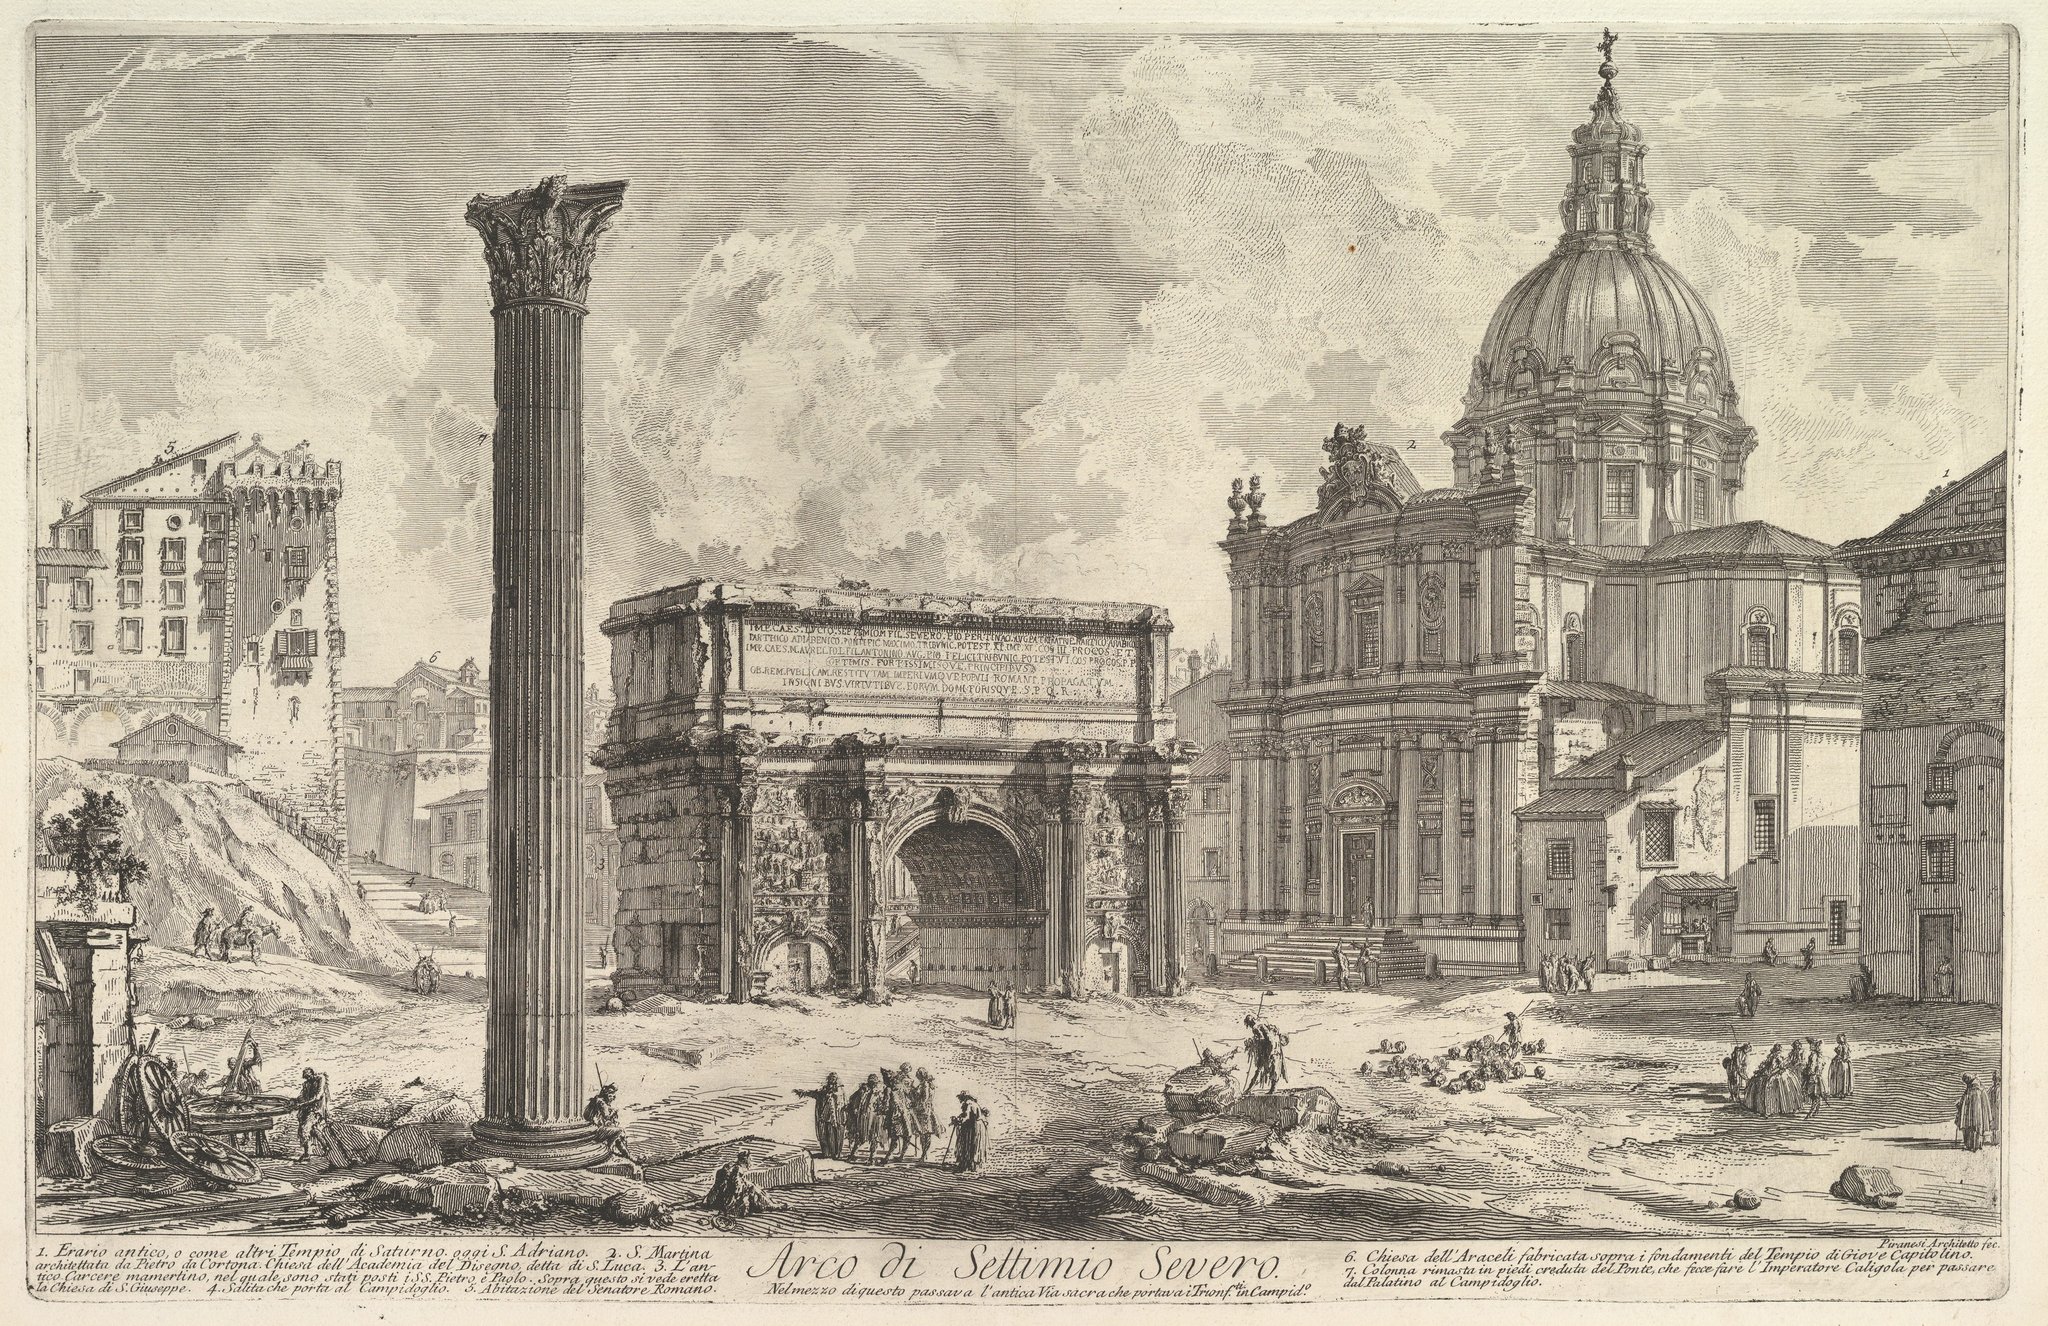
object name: print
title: The Arch of Septimius Severus, with the Church of S. Martina on the right (Arco di Settimio Severo), from "Vedute di Roma"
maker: giovanni battista piranesi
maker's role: artist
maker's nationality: italian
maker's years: 1720-1778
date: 1759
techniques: etching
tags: arches,buildings,columns,churches